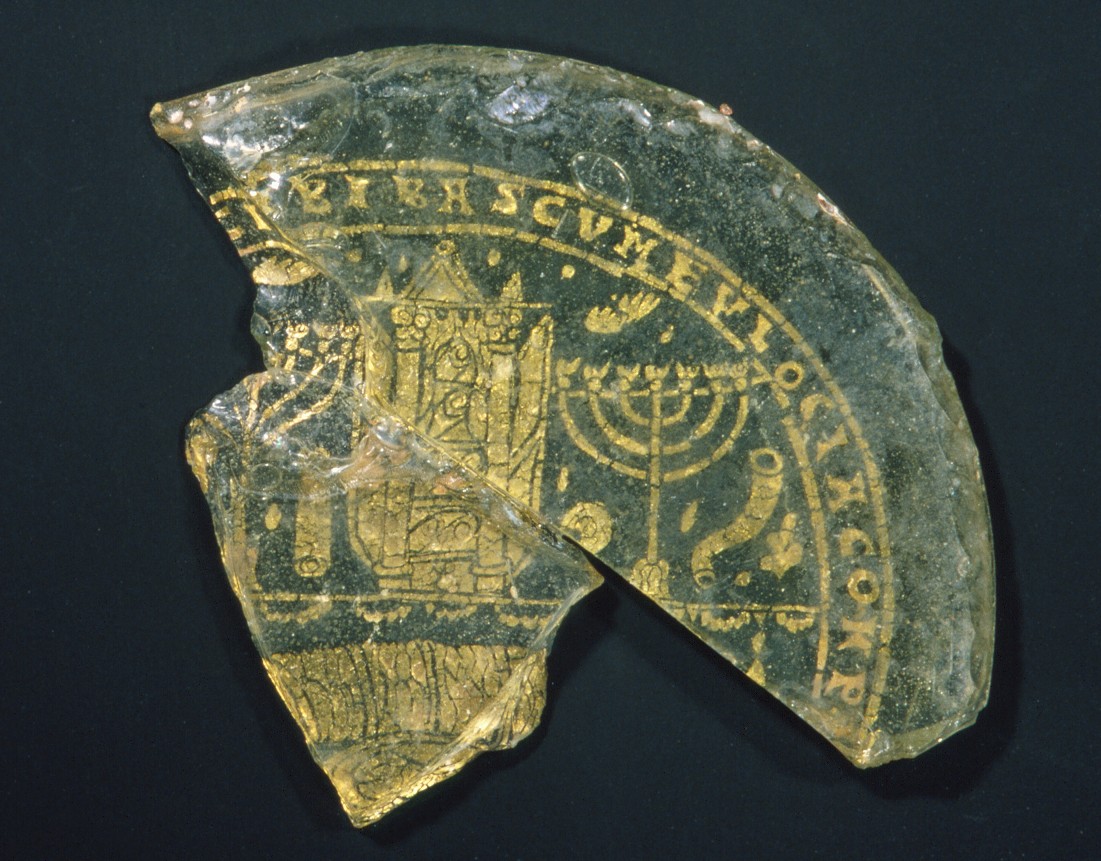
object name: fragment of a bowl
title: Bowl Fragments with Menorah, Shofar, and Torah Ark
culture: roman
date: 300-350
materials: glass, gold leaf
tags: menorah